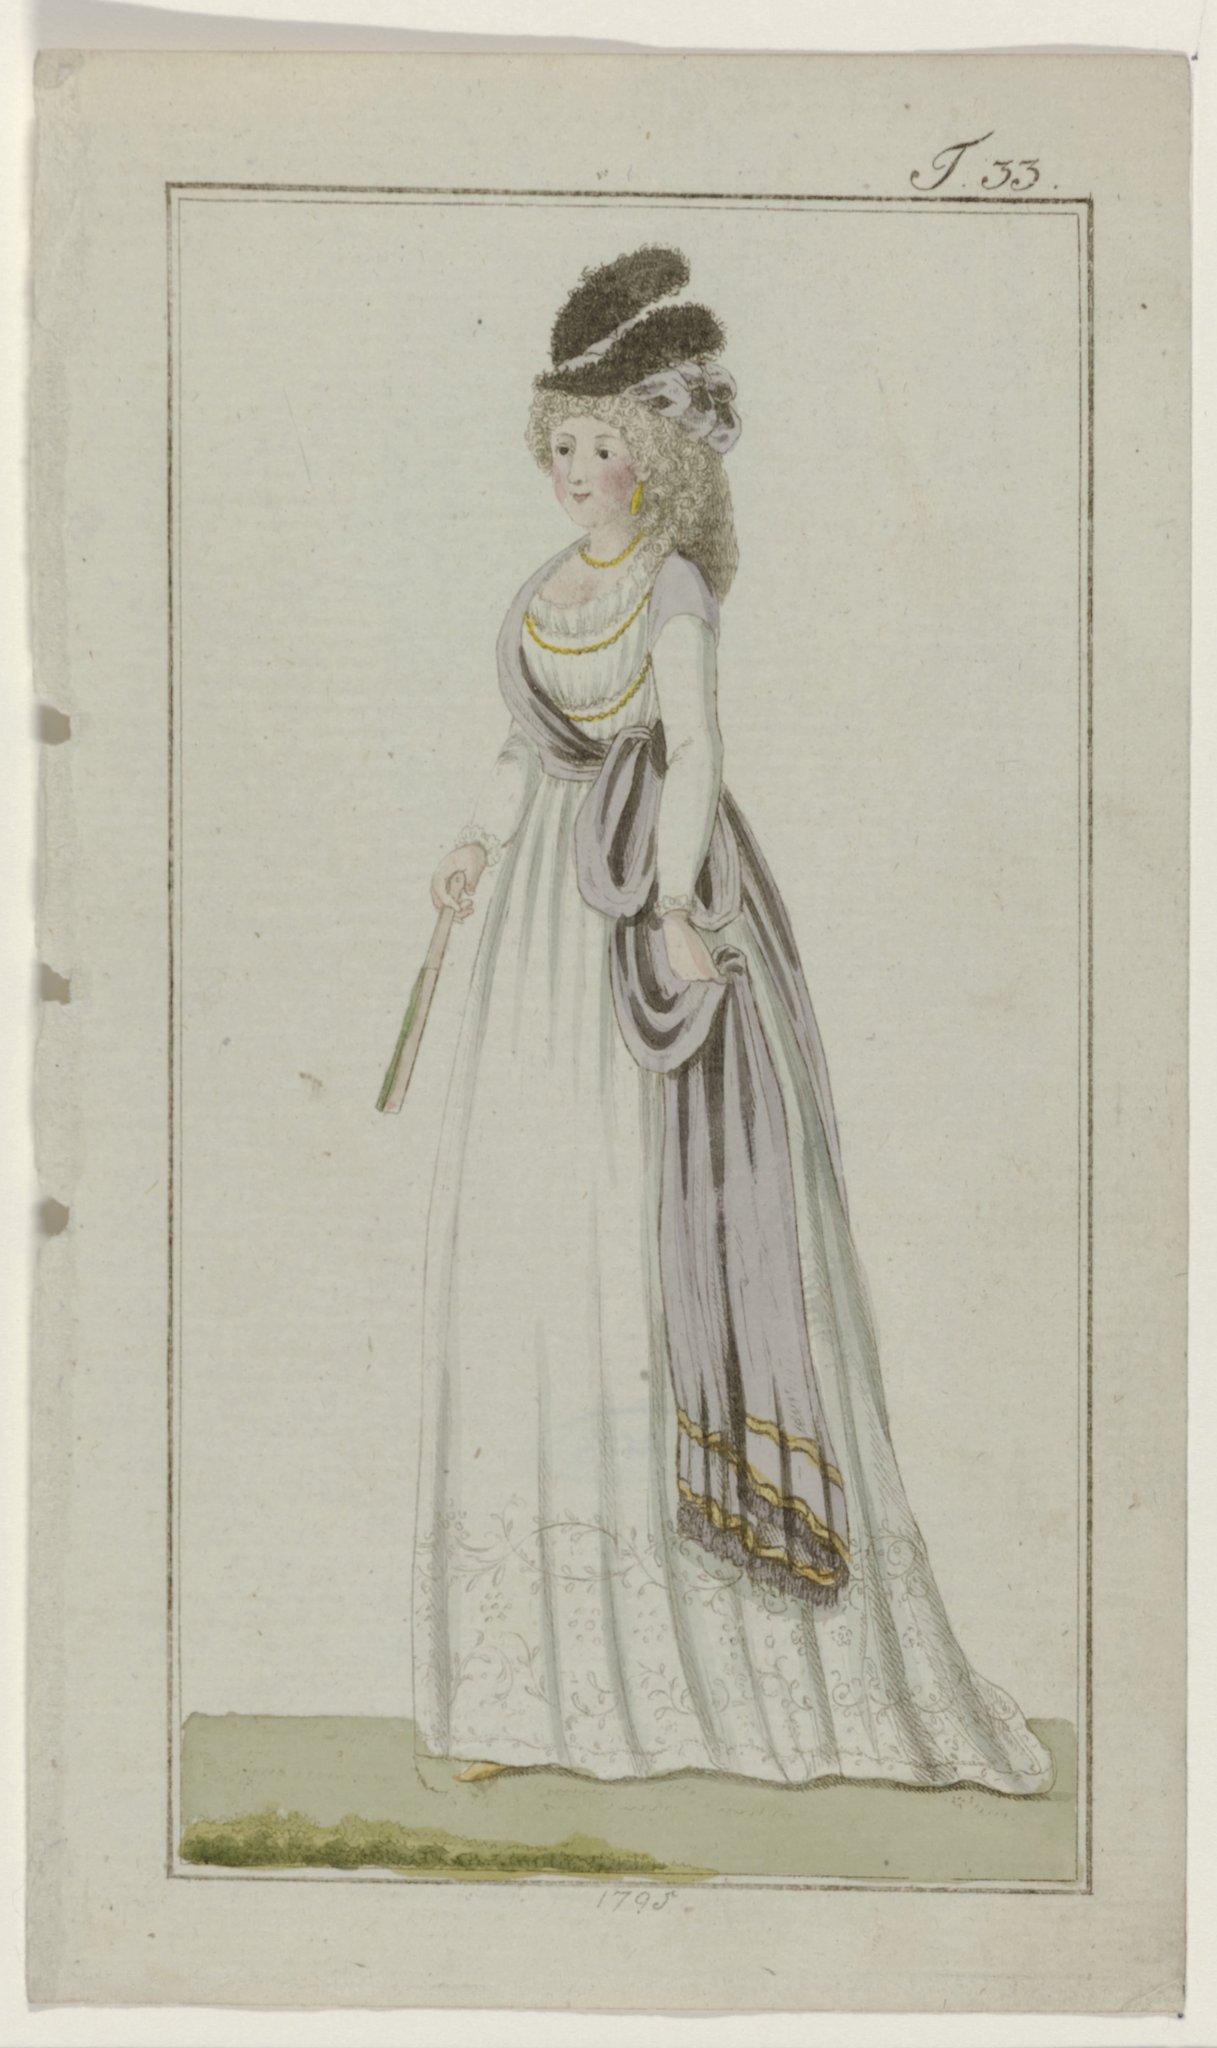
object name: fashion print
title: Journal des Luxus und der Moden, 1795, T 33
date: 1795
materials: paper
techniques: etching, hand coloring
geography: weimar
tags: ear-rings (+ women's clothes), clothing for the upper part of the body (shawl) (+ women's clothes), head-gear: cap (+ women's clothes), fashion plates, shoes, sandals (+ women's clothes), dress, gown (+ women's clothes), fan (+ women's clothes), necklace (+ women's clothes)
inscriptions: date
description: Staande vrouw gekleed in een japon met lange mouwen en sleepje, de zoom versierd met een bloem- en bladmotief. Om de schouders een lange sjaal, bij het middel gestrikt en afgezet met franjes. Verdere accessoires: muts met veren, oorbel in het linkeroor, drie kettingen, waaier. Prent uit het modetijdschrift Journal des Luxus und der Moden, uitgegeven door Friedrich Justin Bertuch en Georg Melchior Kraus, Weimar, 1786-1826.